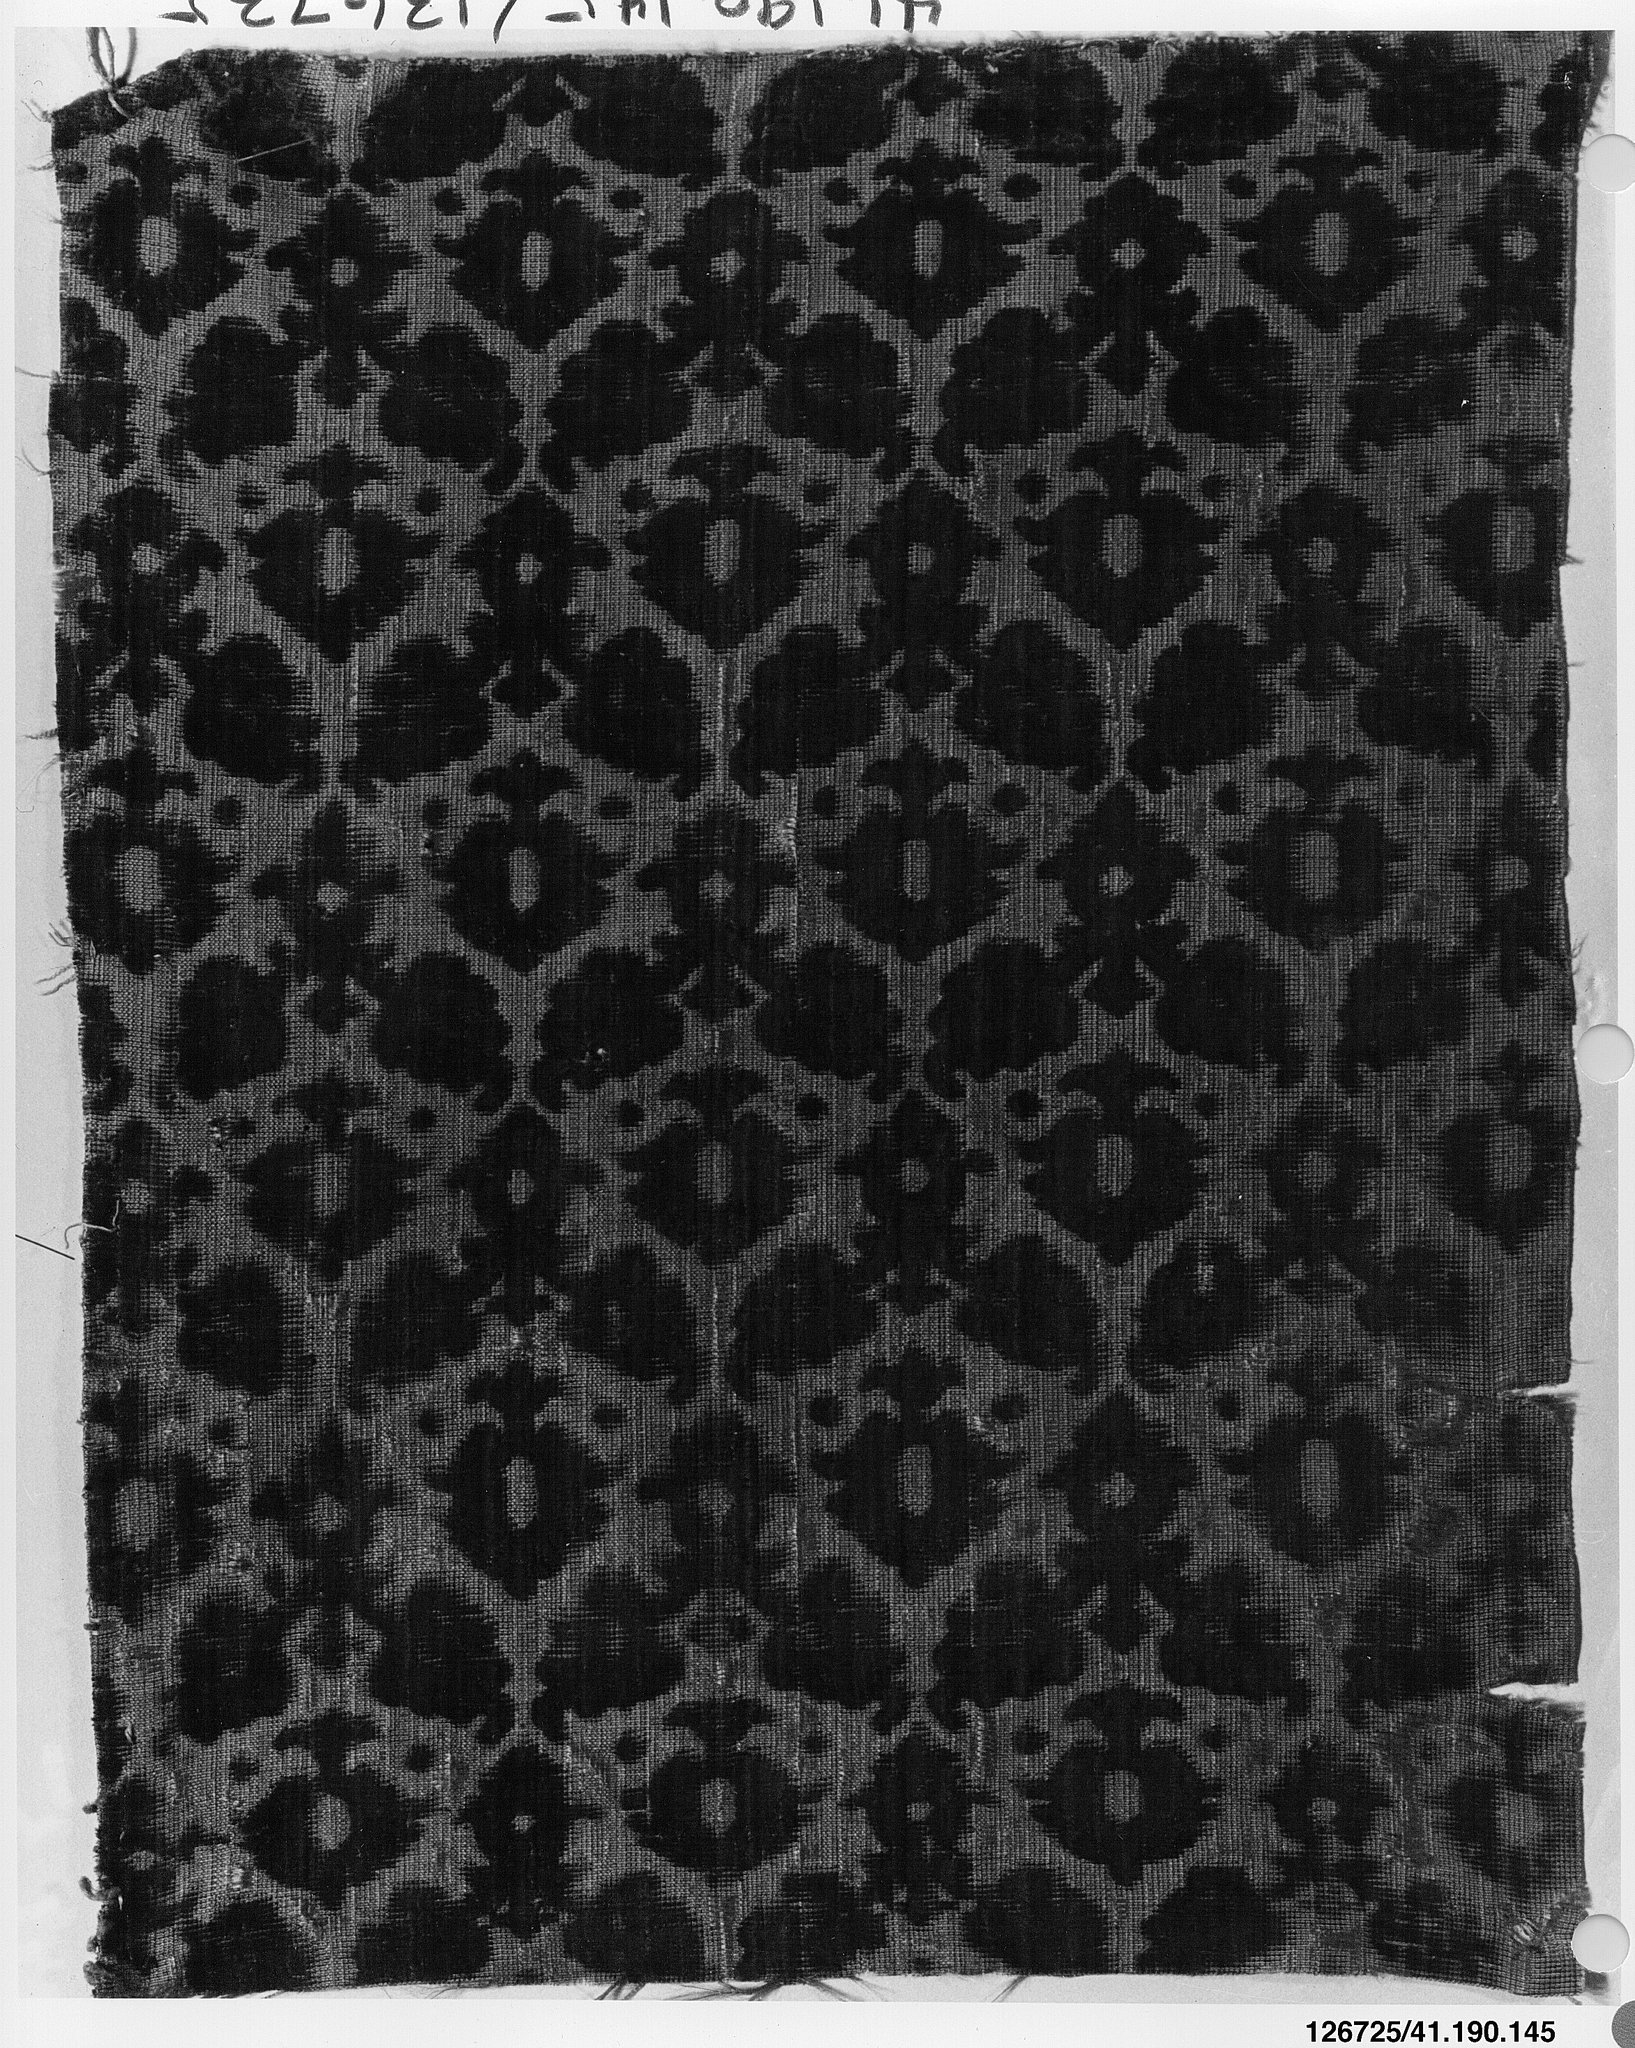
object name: piece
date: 1601-1633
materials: silk